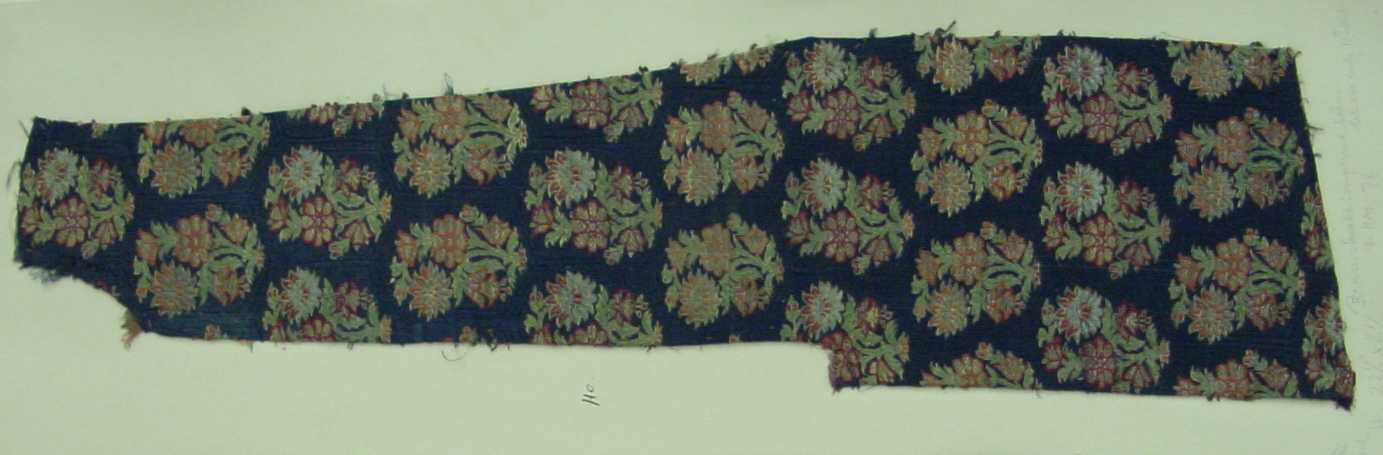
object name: textile fragment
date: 1601-1800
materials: metal thread, silk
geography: iran